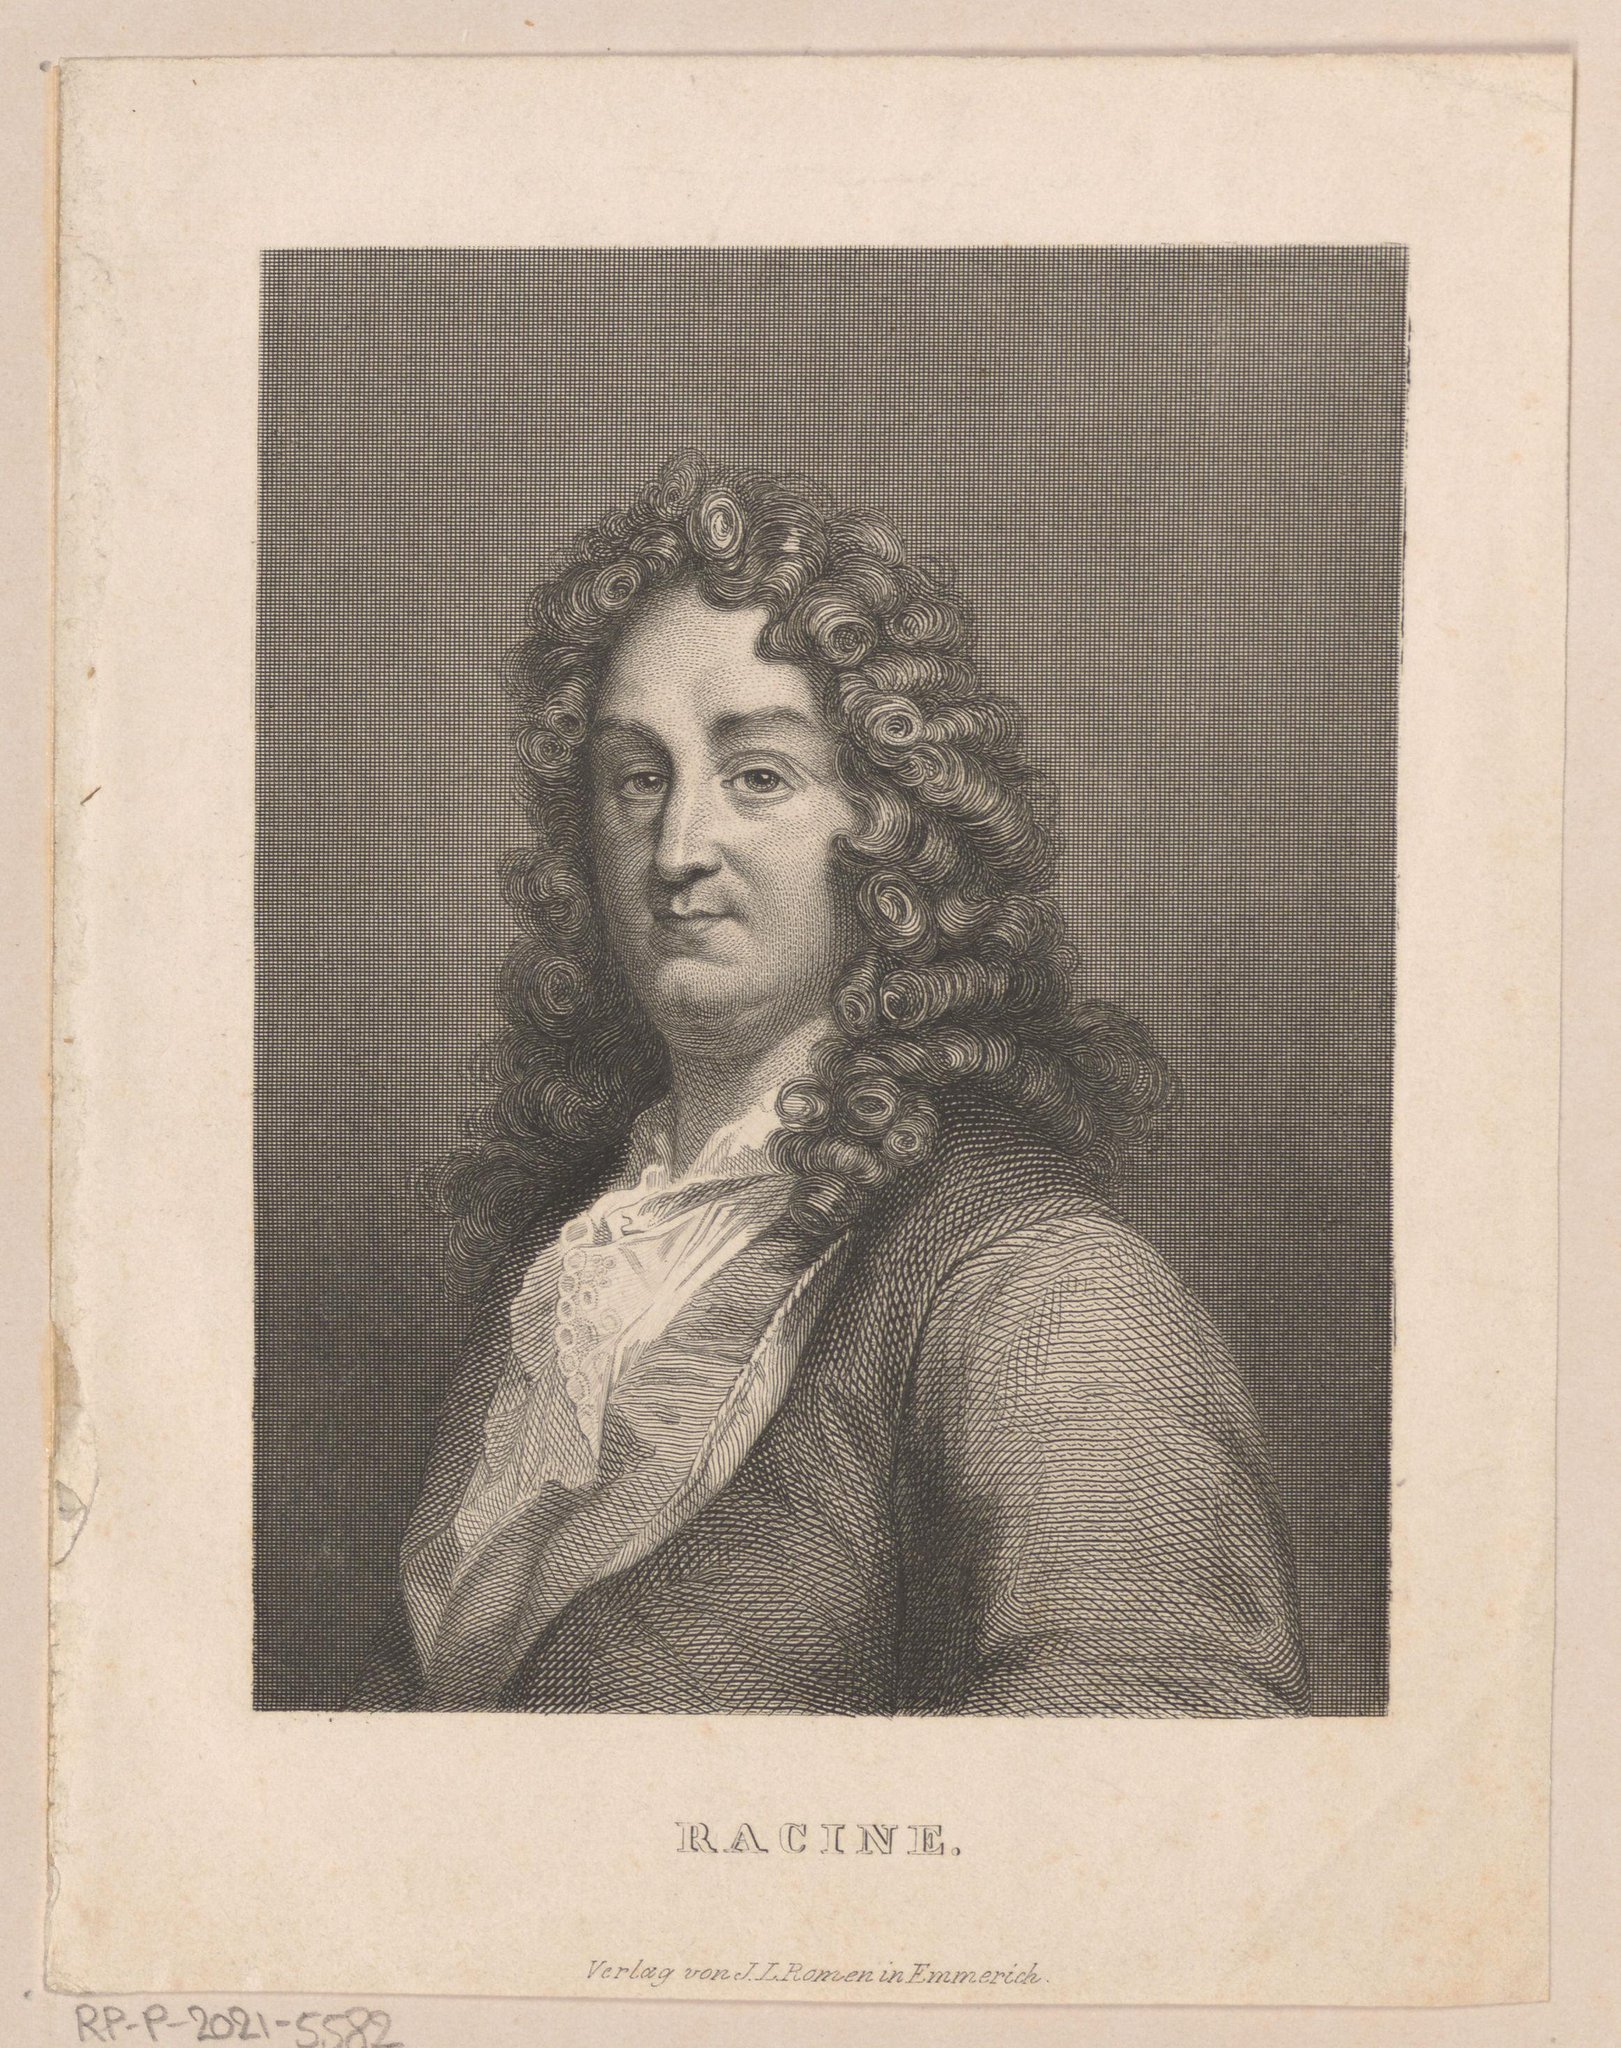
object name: print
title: Portret van Jean Racine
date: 1800-1899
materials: paper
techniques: engraving, etching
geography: emmerik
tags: france, paris, jean racine, historical persons